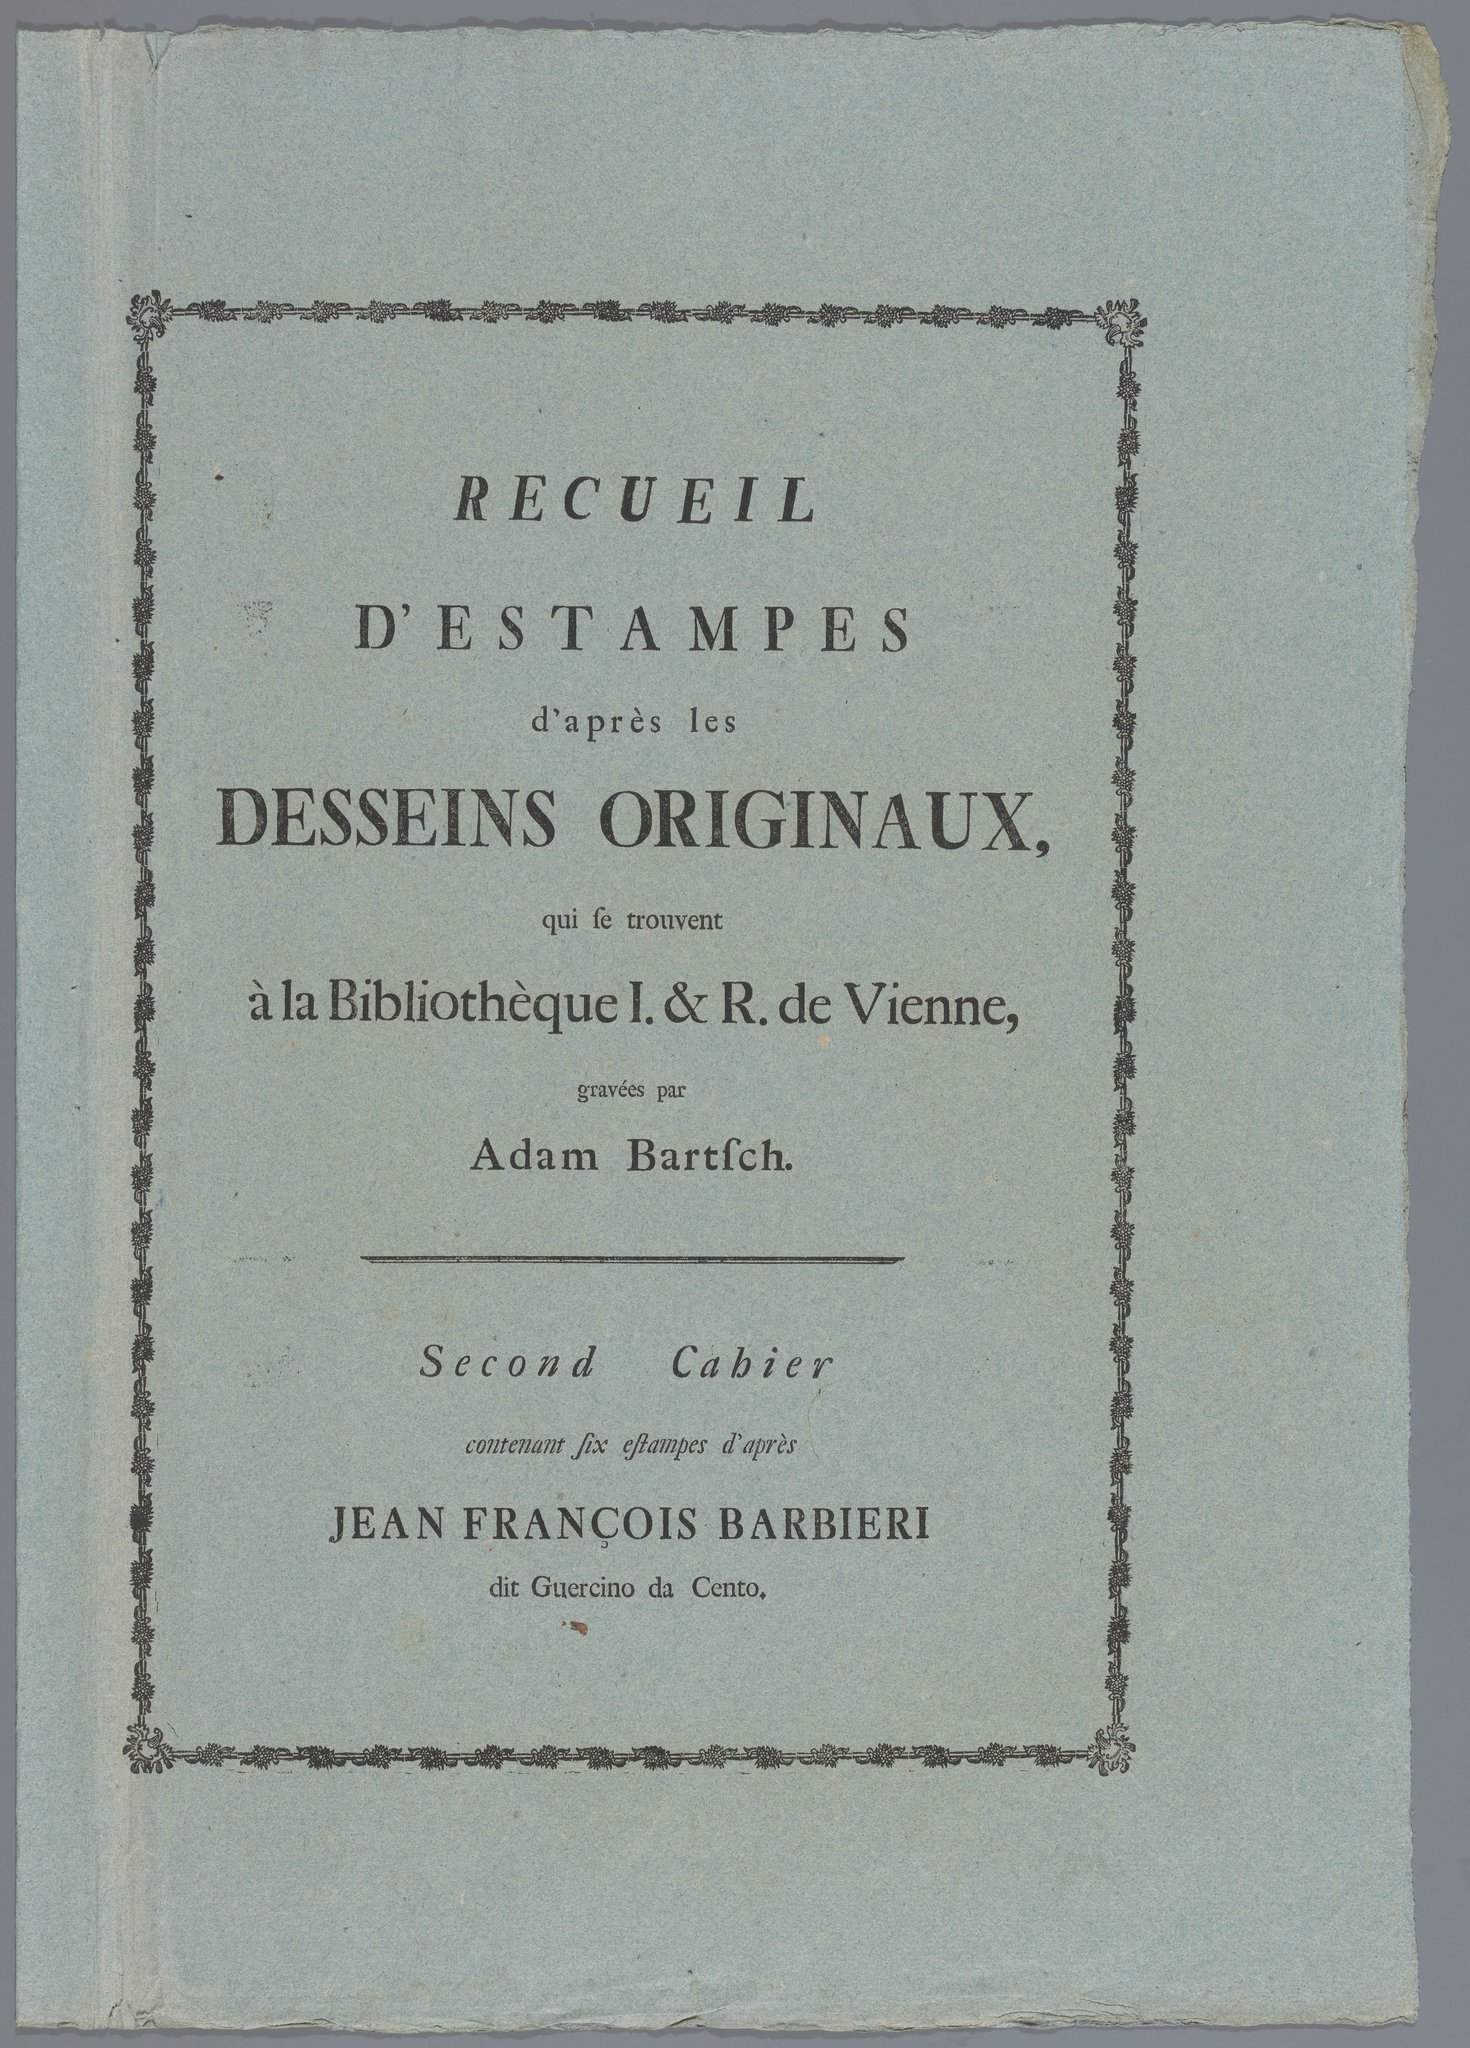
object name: wrapper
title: Prenten naar tekeningen van Guercino bewaard in de Hofbibliothek te Wenen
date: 1783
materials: paper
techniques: letterpress printing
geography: vienna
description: Tweede van in totaal zes afleveringen met prenten door Adam von Bartsch naar tekeningen van onder meer Rembrandt, Dürer, Guercino, Parmigianino en Lafage, bewaard in de Hofbibliothek te Wenen. Op de achterzijde van de omslag een beschrijving van de zes prenten.